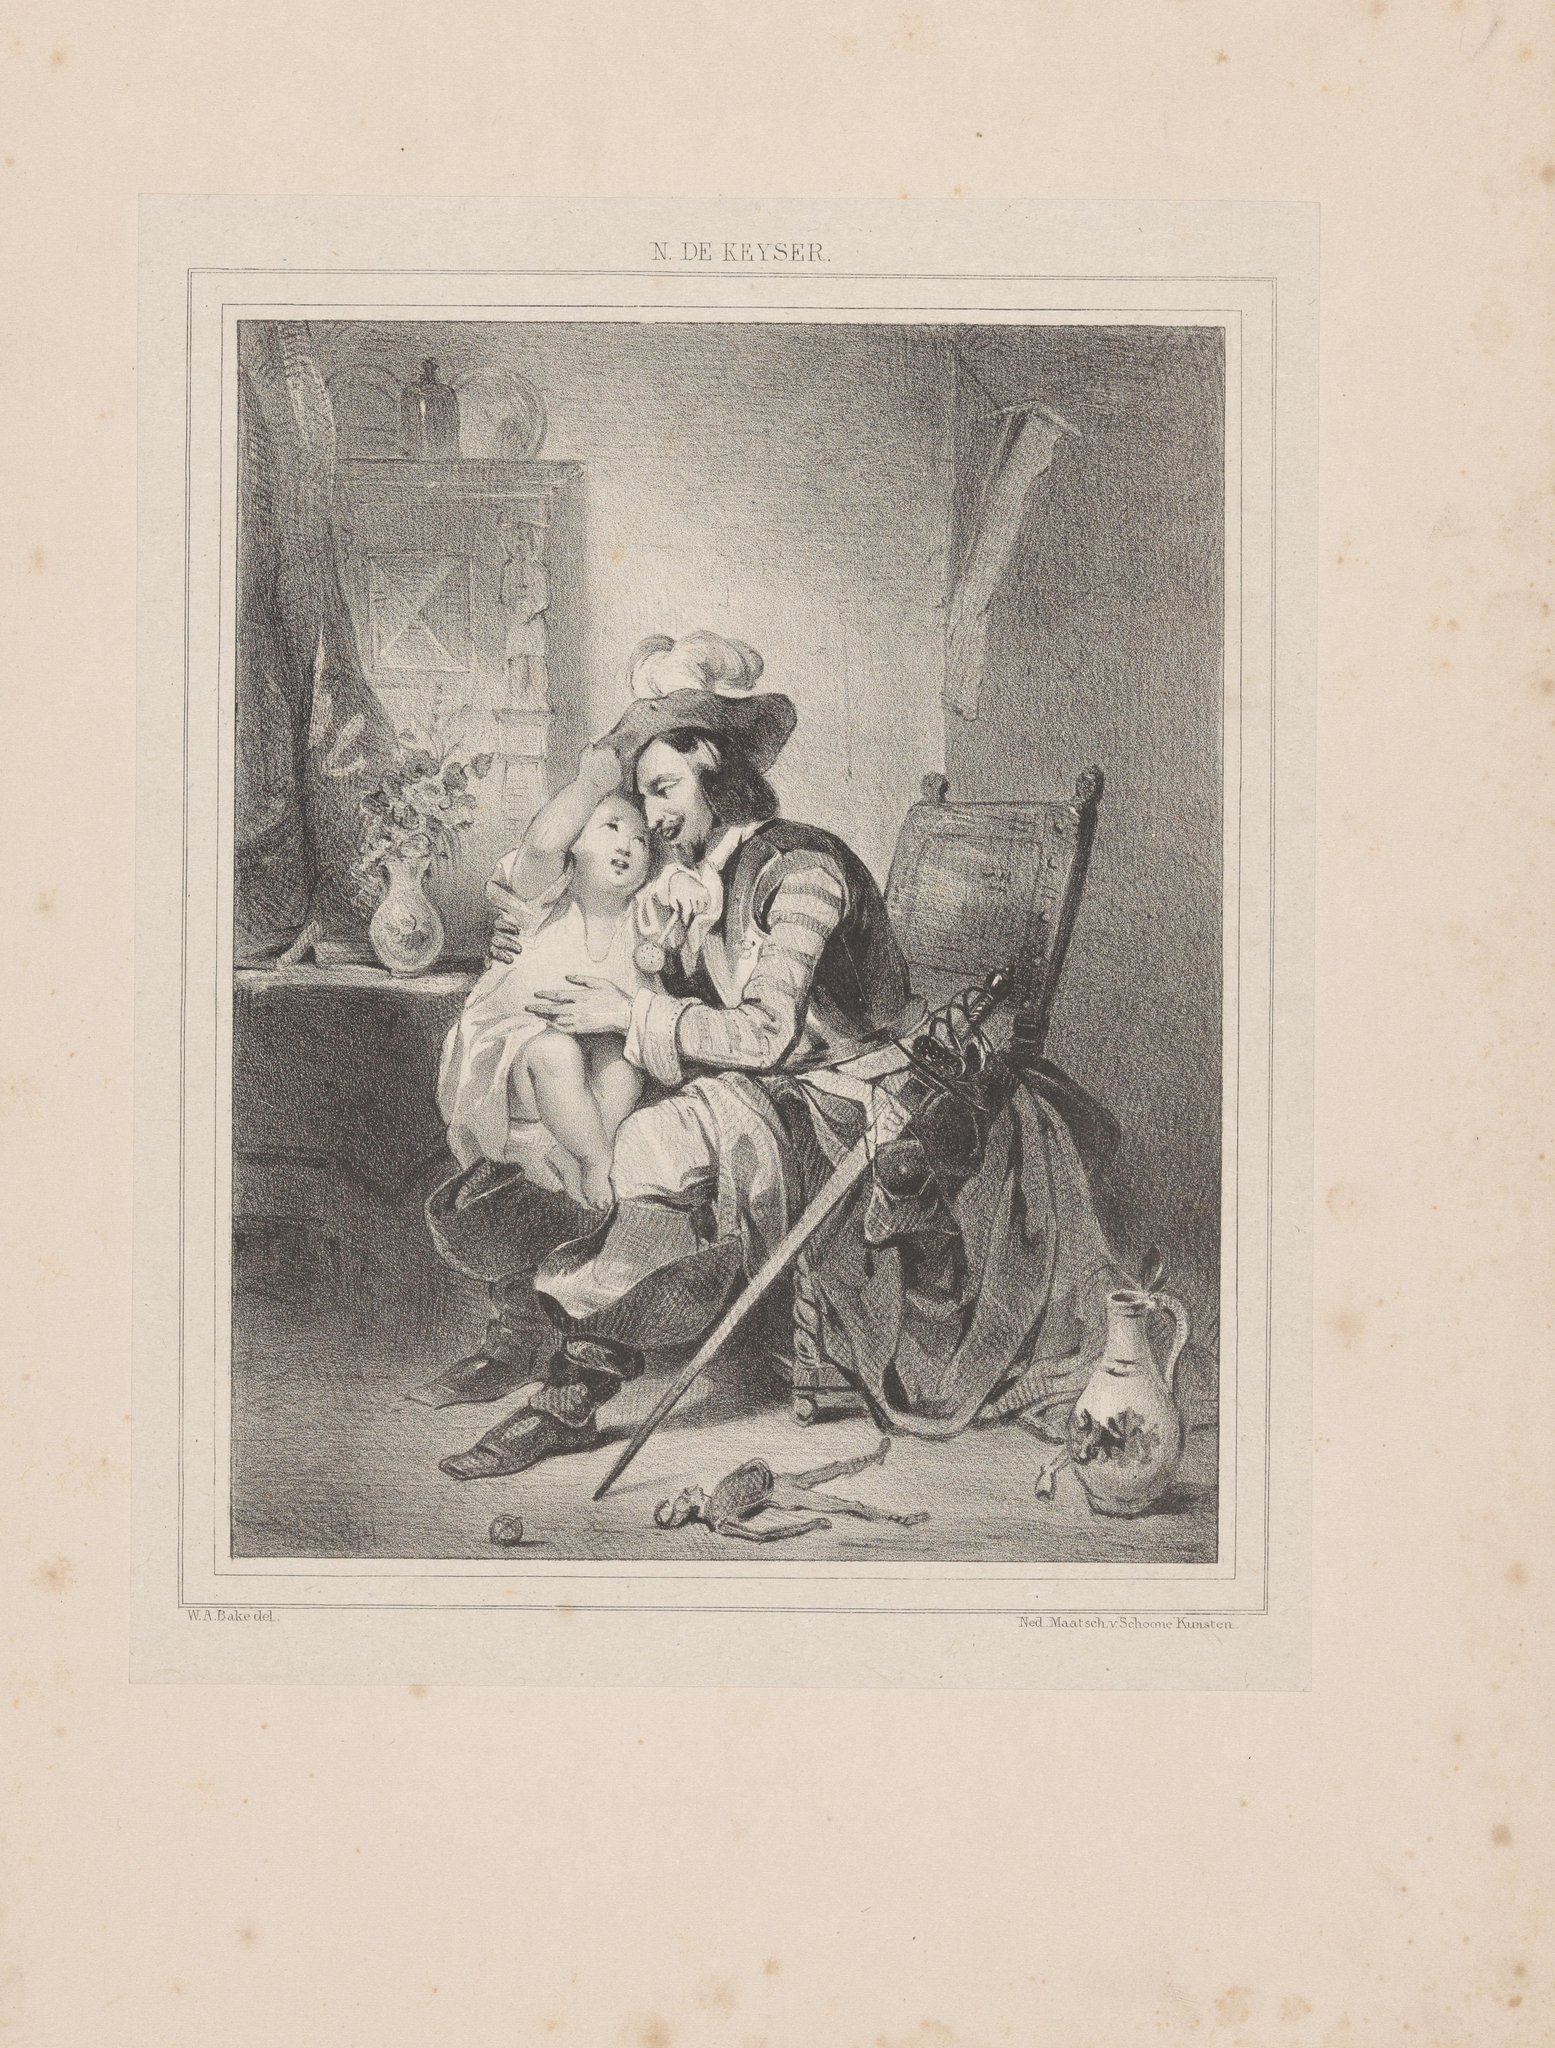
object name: print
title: Zittende ridder met kind op schoot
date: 1840-1843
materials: paper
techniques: lithograph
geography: the hague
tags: infant, baby, knight, rattle (child's toy)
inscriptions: collector's mark: Lugt 2228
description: Het kind trekt aan de hoed van de ridder. In zijn andere hand heeft hij een rammelaar. Op de grond liggen een pop, een bal, een karaf en een pijp. Op tafel staat een bos bloemen in een vaas.